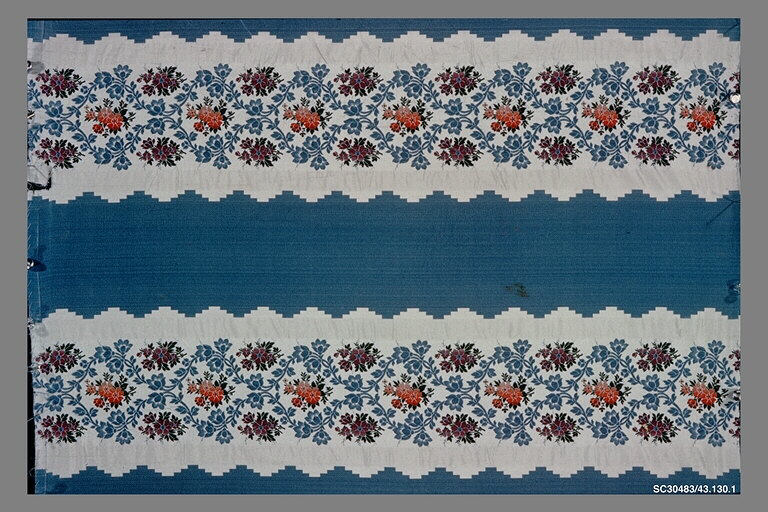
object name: piece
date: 1860-1870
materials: silk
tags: flowers,leaves